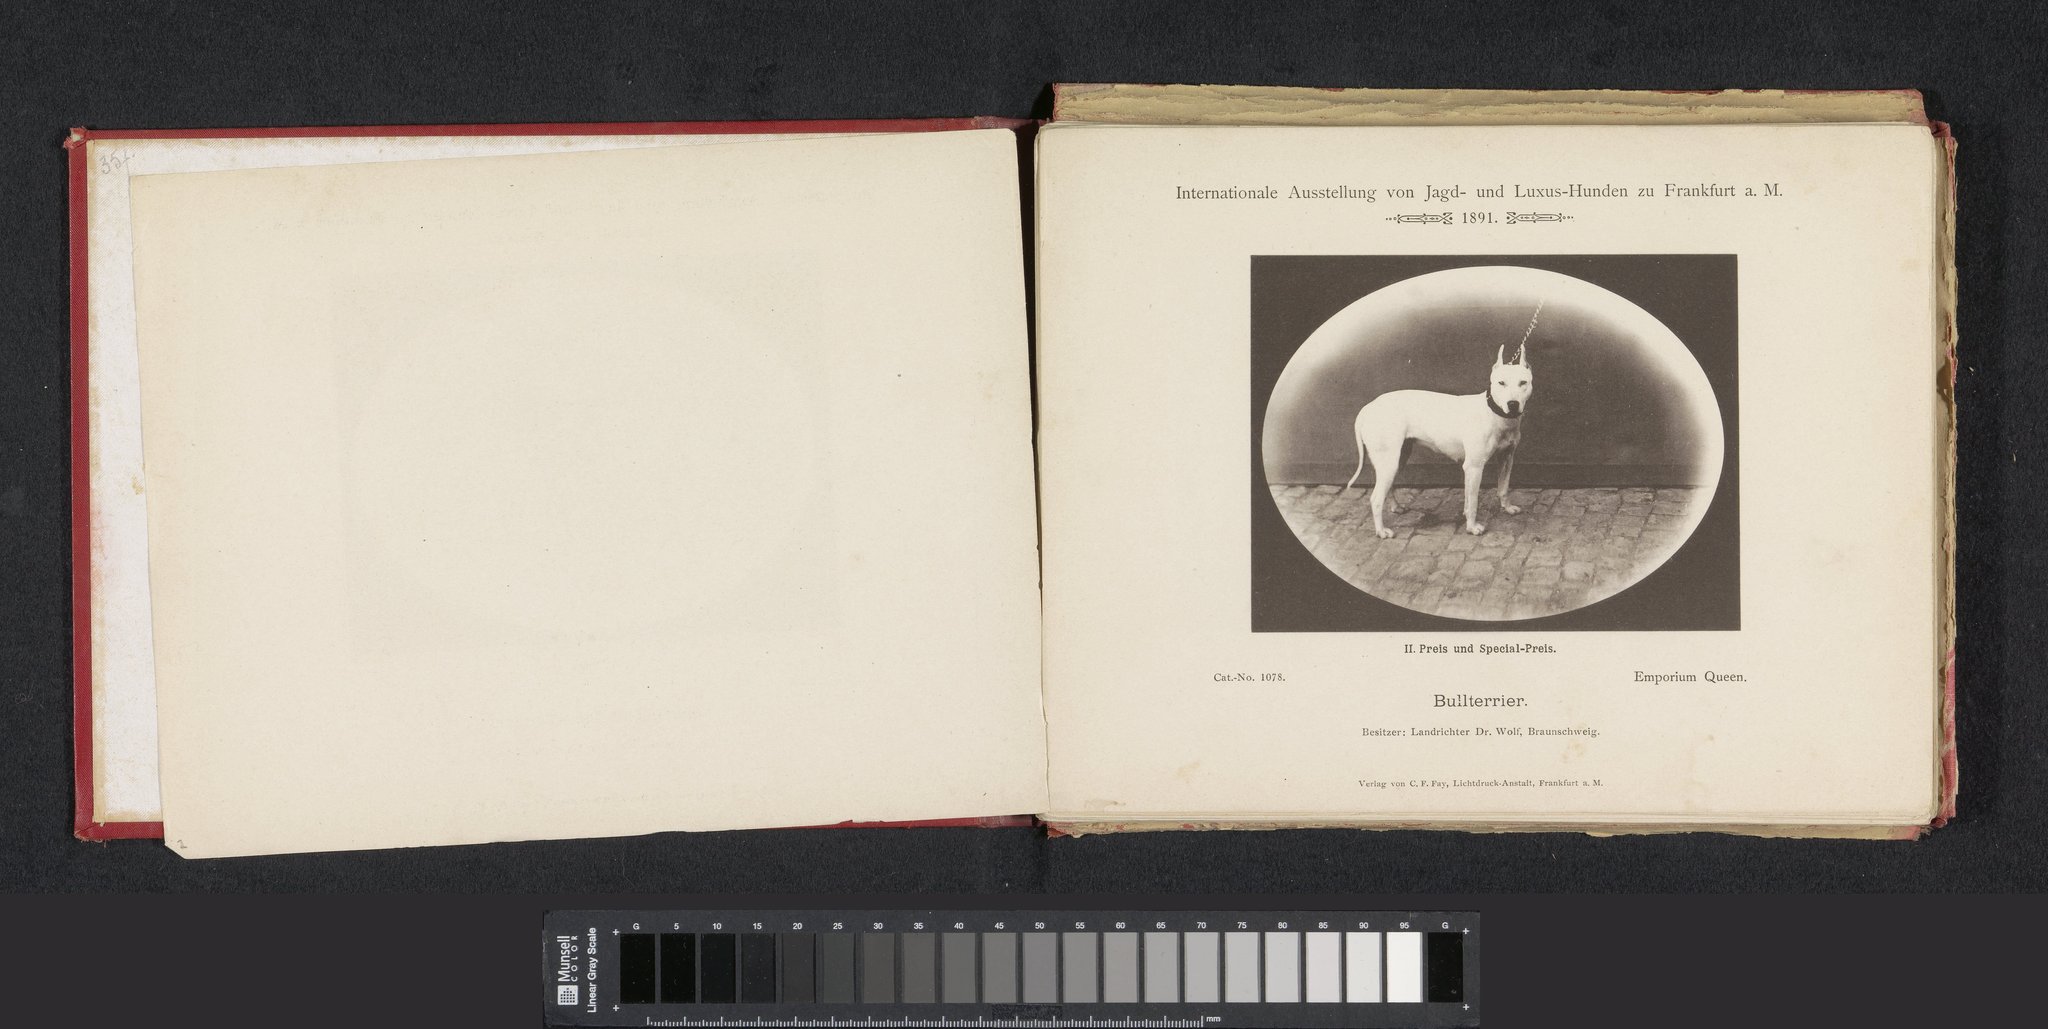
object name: page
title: Internationale Ausstellung von Jagd- und Luxus-Hunden zu Frankfurt a. M. 1891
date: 1891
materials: paper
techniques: photograph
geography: frankfurt am main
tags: dog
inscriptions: inscription: ‘II. Preis und Special-Preis. Emporium Queen. Besitzer : Landrichter Dr. Wolf, Braunschweig.’, number: ‘Cat.-No. 1078.’